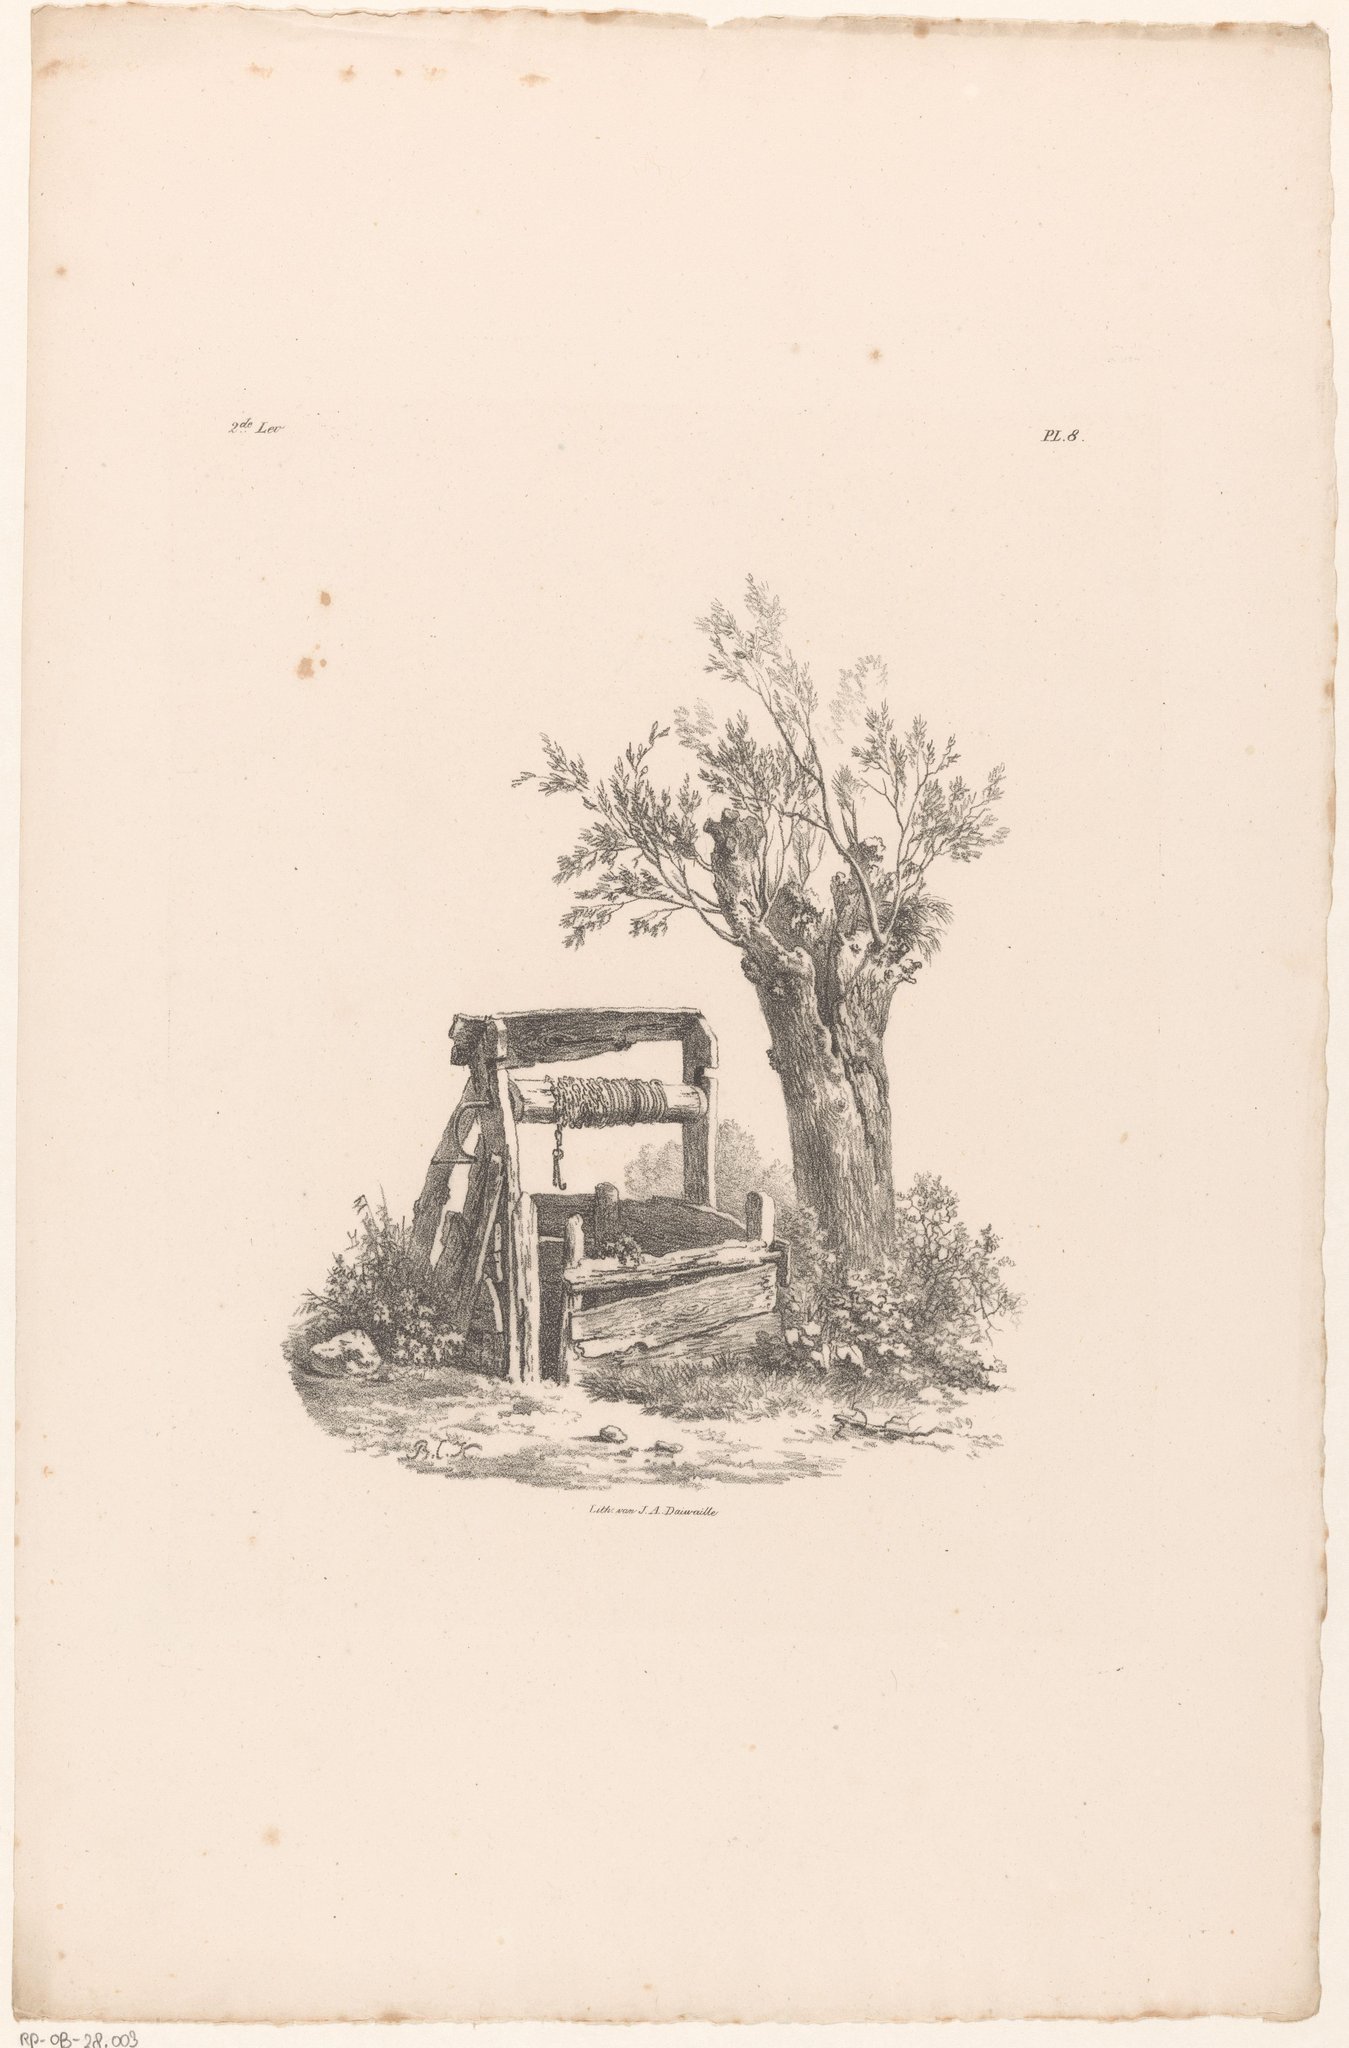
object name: print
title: Waterput bij een knotwilg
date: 1809-1850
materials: paper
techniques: lithograph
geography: amsterdam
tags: well, trees: willow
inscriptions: collector's mark: Lugt 2228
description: De waterput is vervallen. Genummerd rechtsboven: 'Pl. 8' en linksboven: '2e lev'.